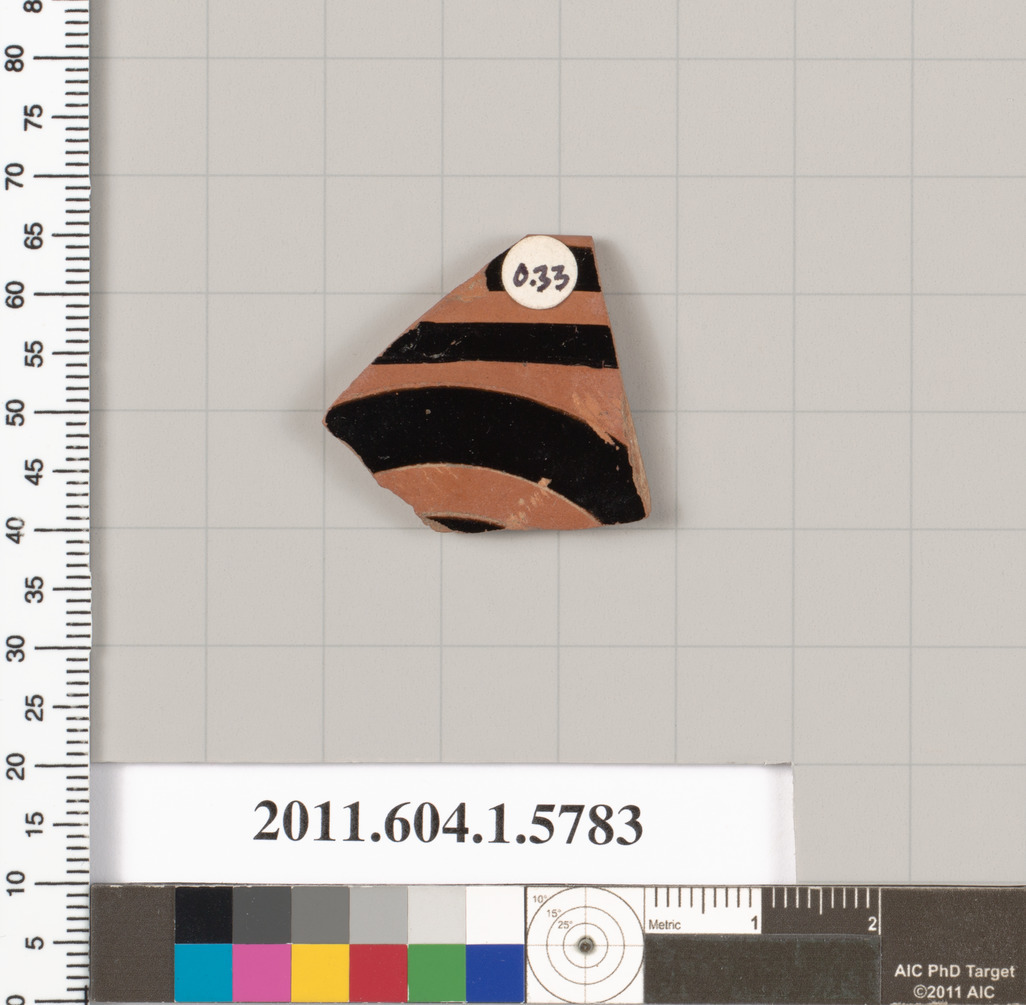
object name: kylix fragment, eye cup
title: Terracotta rim fragment of a kylix: eye-cup (drinking cup)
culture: greek, attic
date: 525-510 BCE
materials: terracotta